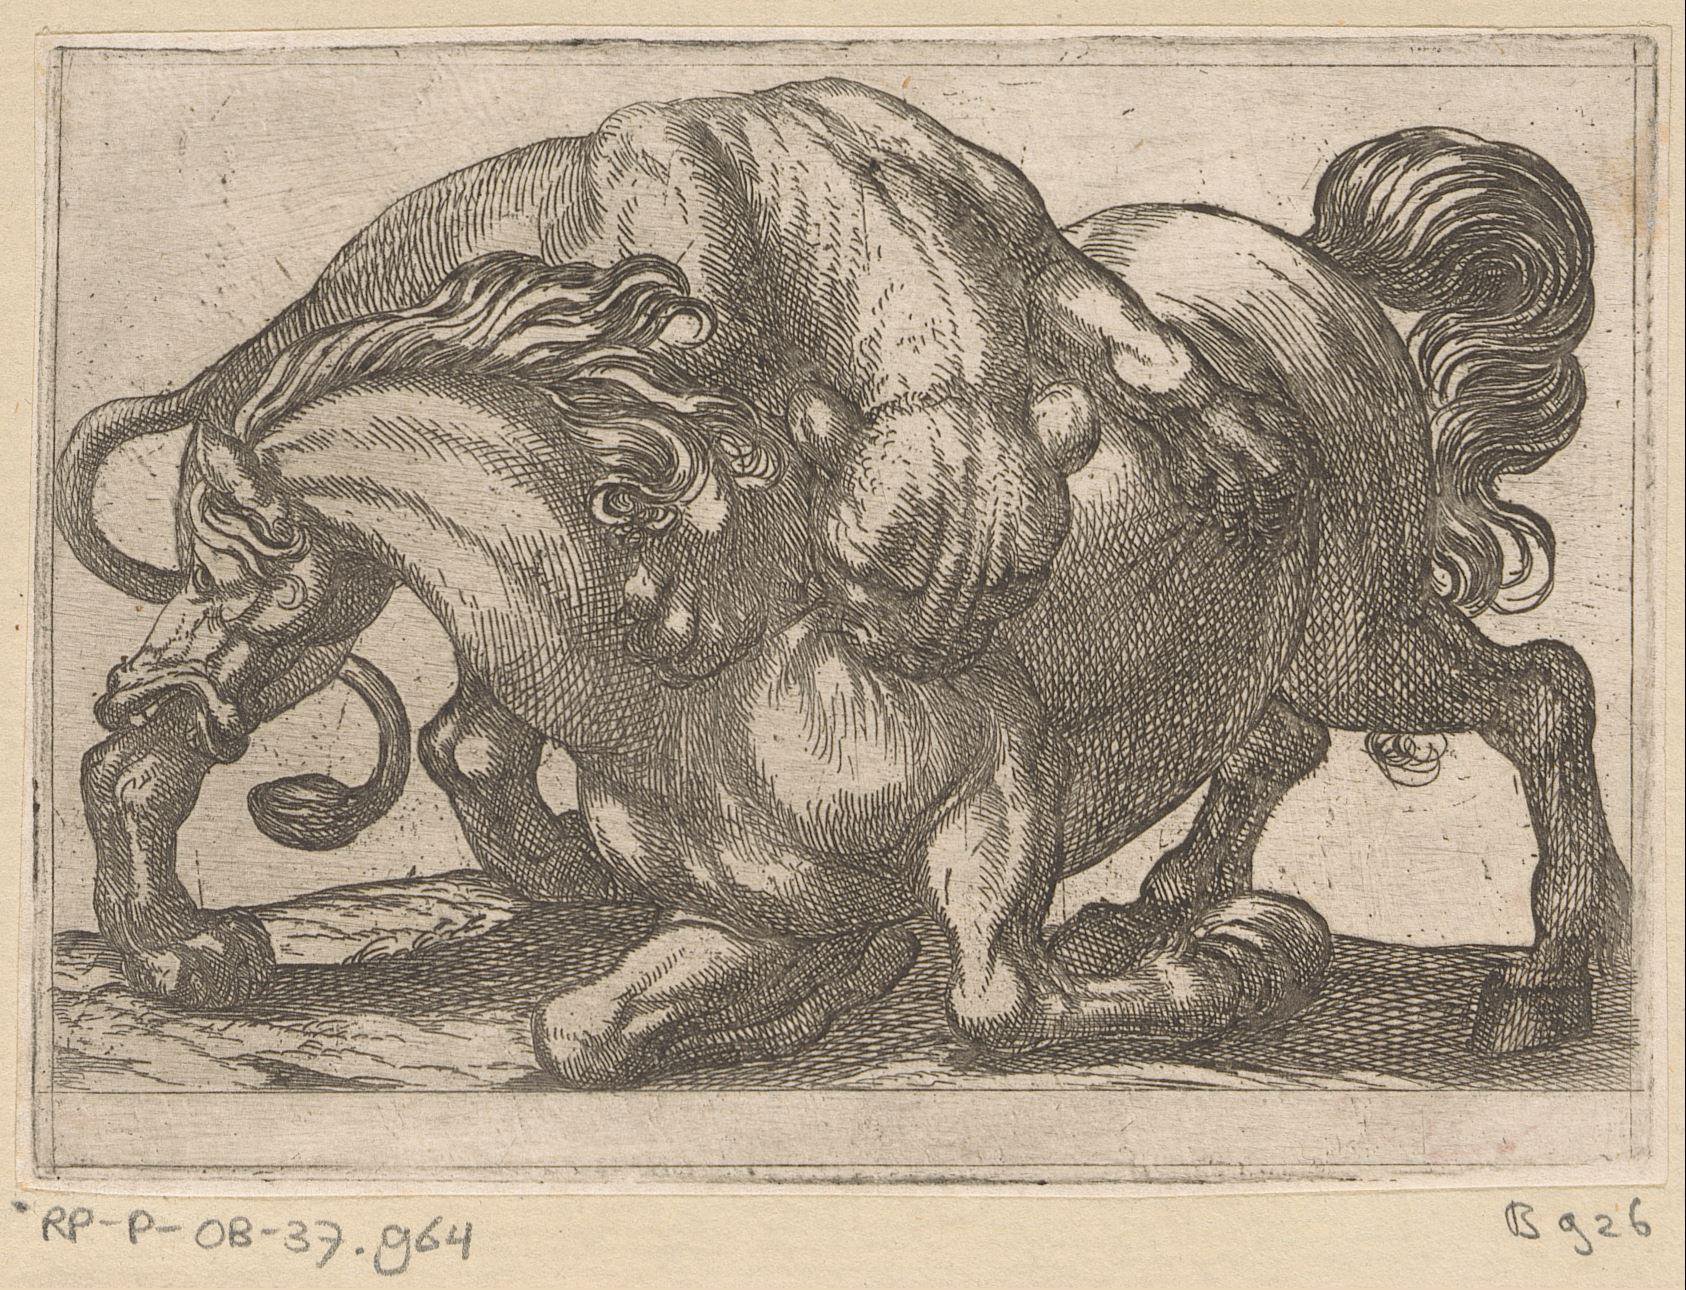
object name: print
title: Vechtende dieren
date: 1600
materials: paper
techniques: etching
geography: rome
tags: horse, beasts of prey, predatory animals: lion, fighting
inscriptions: collector's mark: Lugt 240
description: Deze prent maakt deel uit van een reeks van 25 prenten (+ titelprent) van vechtende dieren.